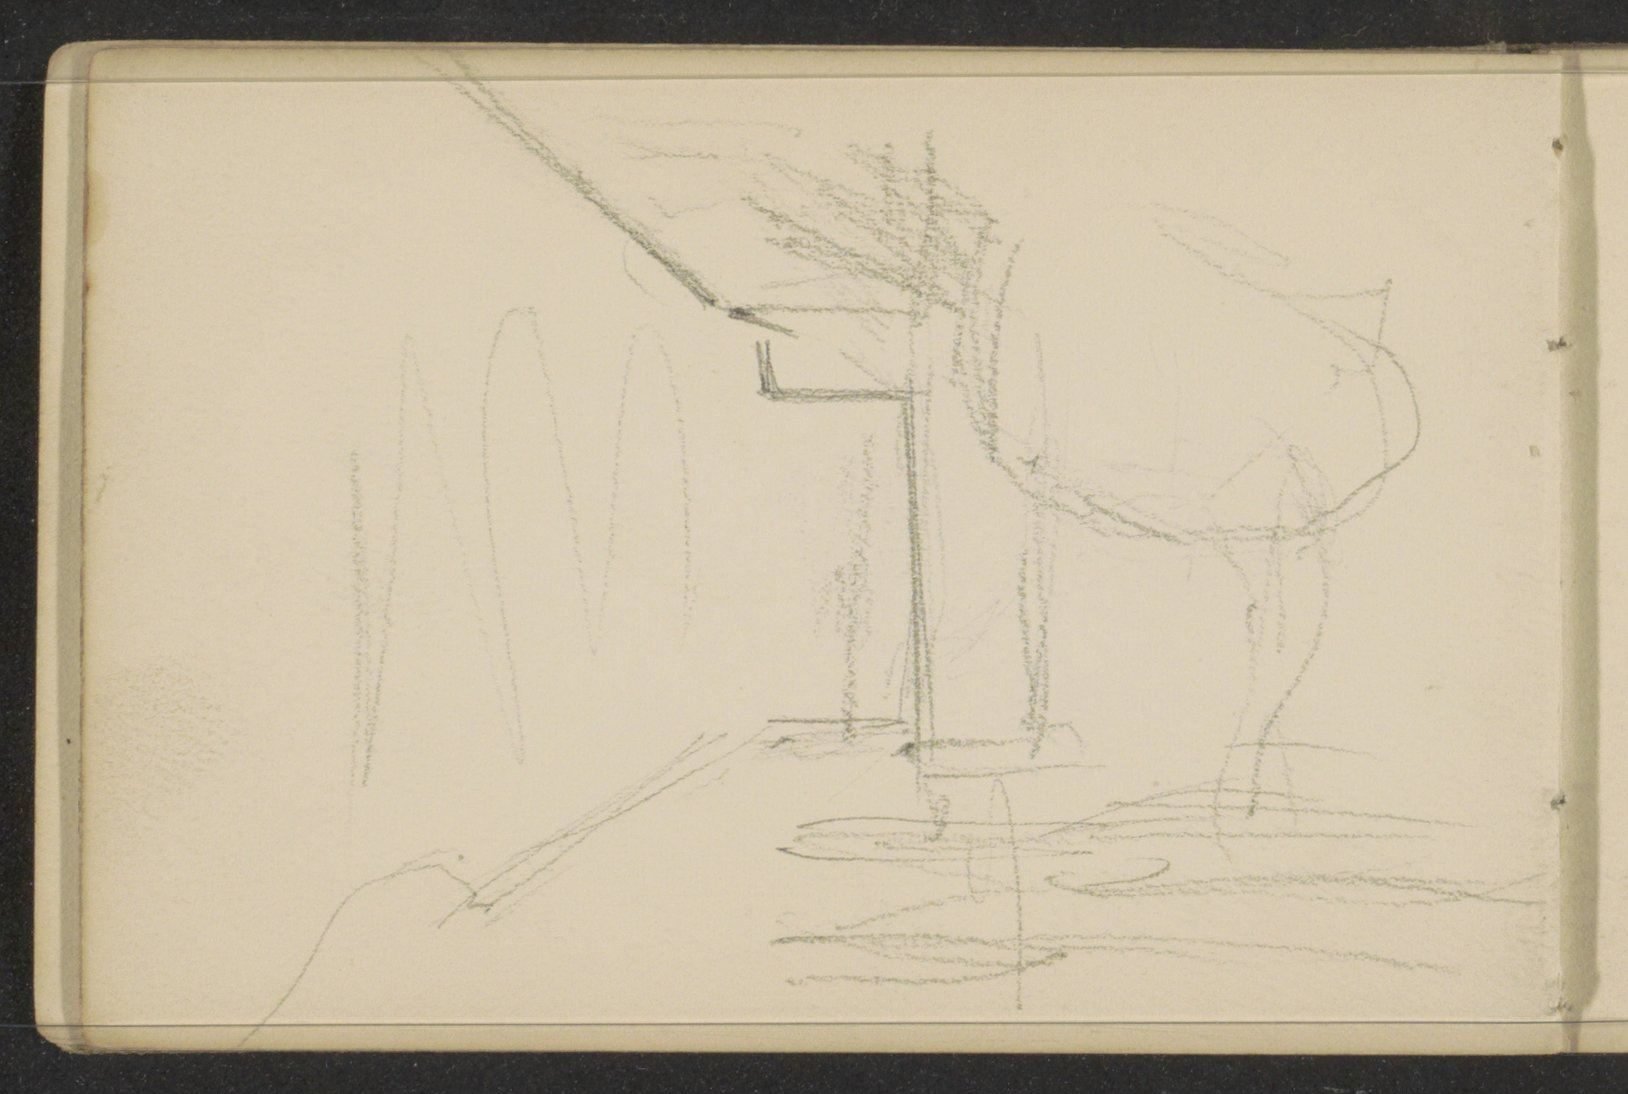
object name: sketchbook leaf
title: Brug over een kanaal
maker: Anonymous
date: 1880-1900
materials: paper, pencil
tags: landscapes with waters, waterscapes, seascapes (in the temperate zone), bridge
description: Blad 7 verso uit een schetsboek met 29 bladen.